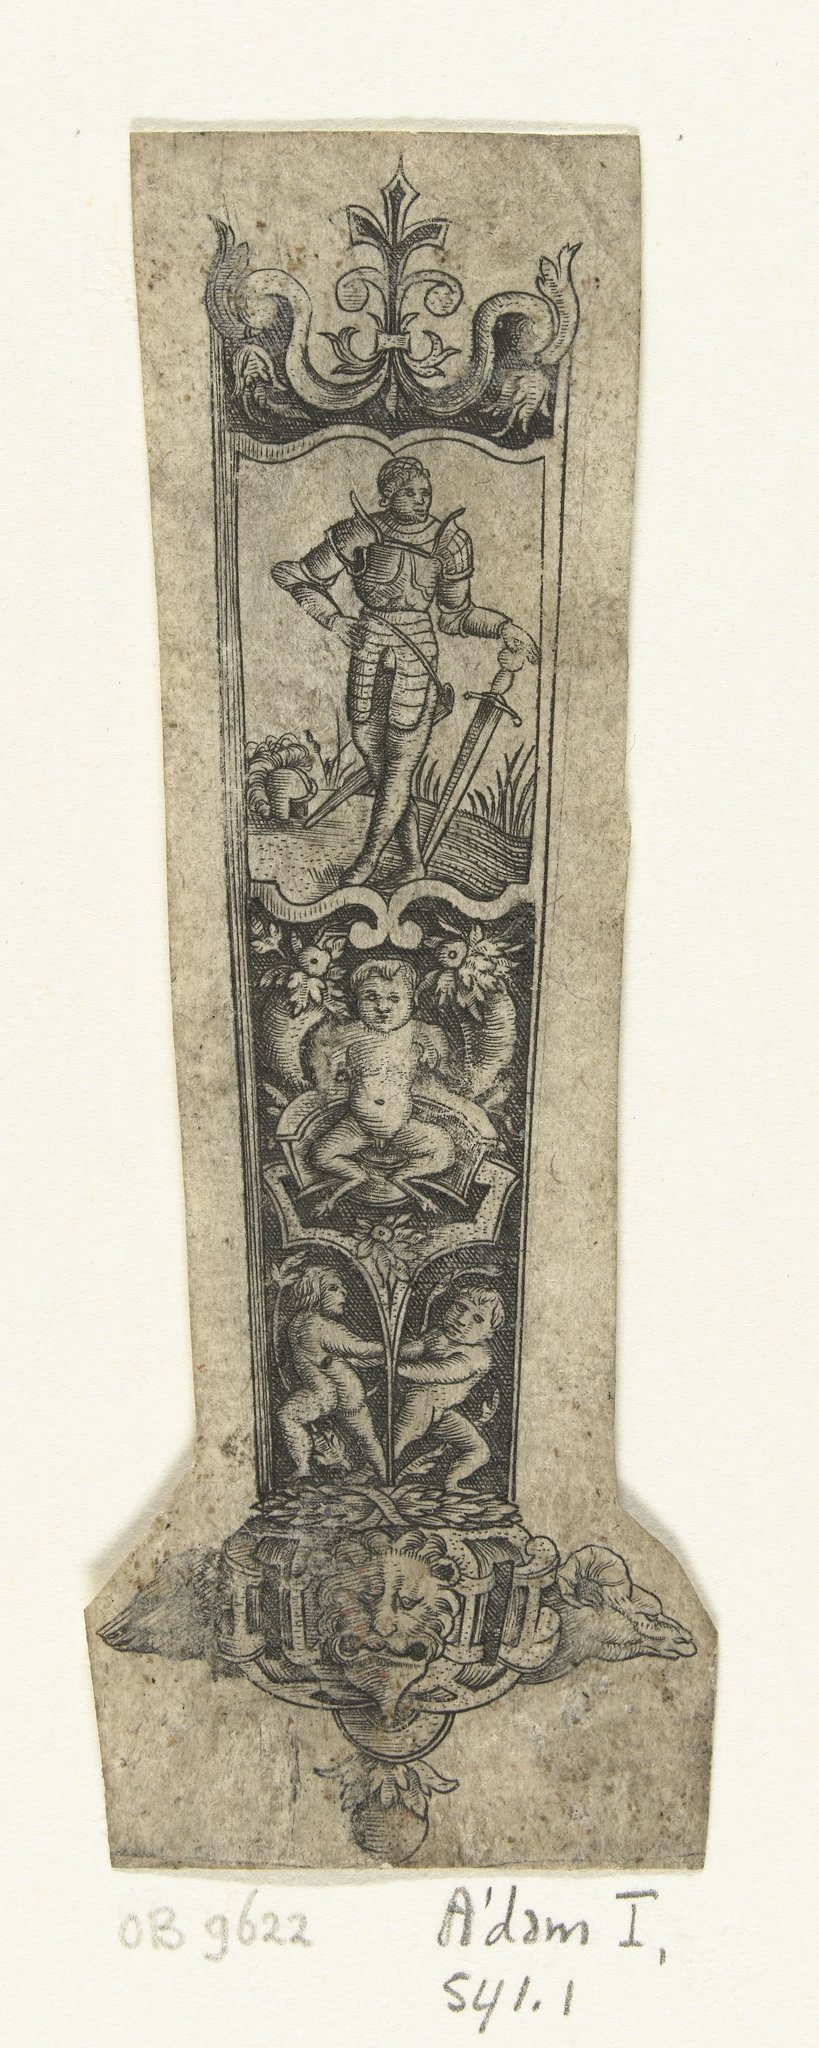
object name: print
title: Teras Nowo widane y Drukowan (...)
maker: Anonymous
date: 1500-1552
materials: paper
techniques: engraving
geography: eastern europe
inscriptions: collector's mark: Lugt 240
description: Twee kinderen staan bij een constructie van rolwerk waarop een satertje zit tussen twee hoorns des overvloeds. Daarboven leunt een man in wapenrusting op zijn zwaard. De knop onderaan is gedecoreerd in de vorm van een zwijnskop, een leeuwenkop en een ramskop. Uit serie, bestaande uit een titelblad en 12 bladen.